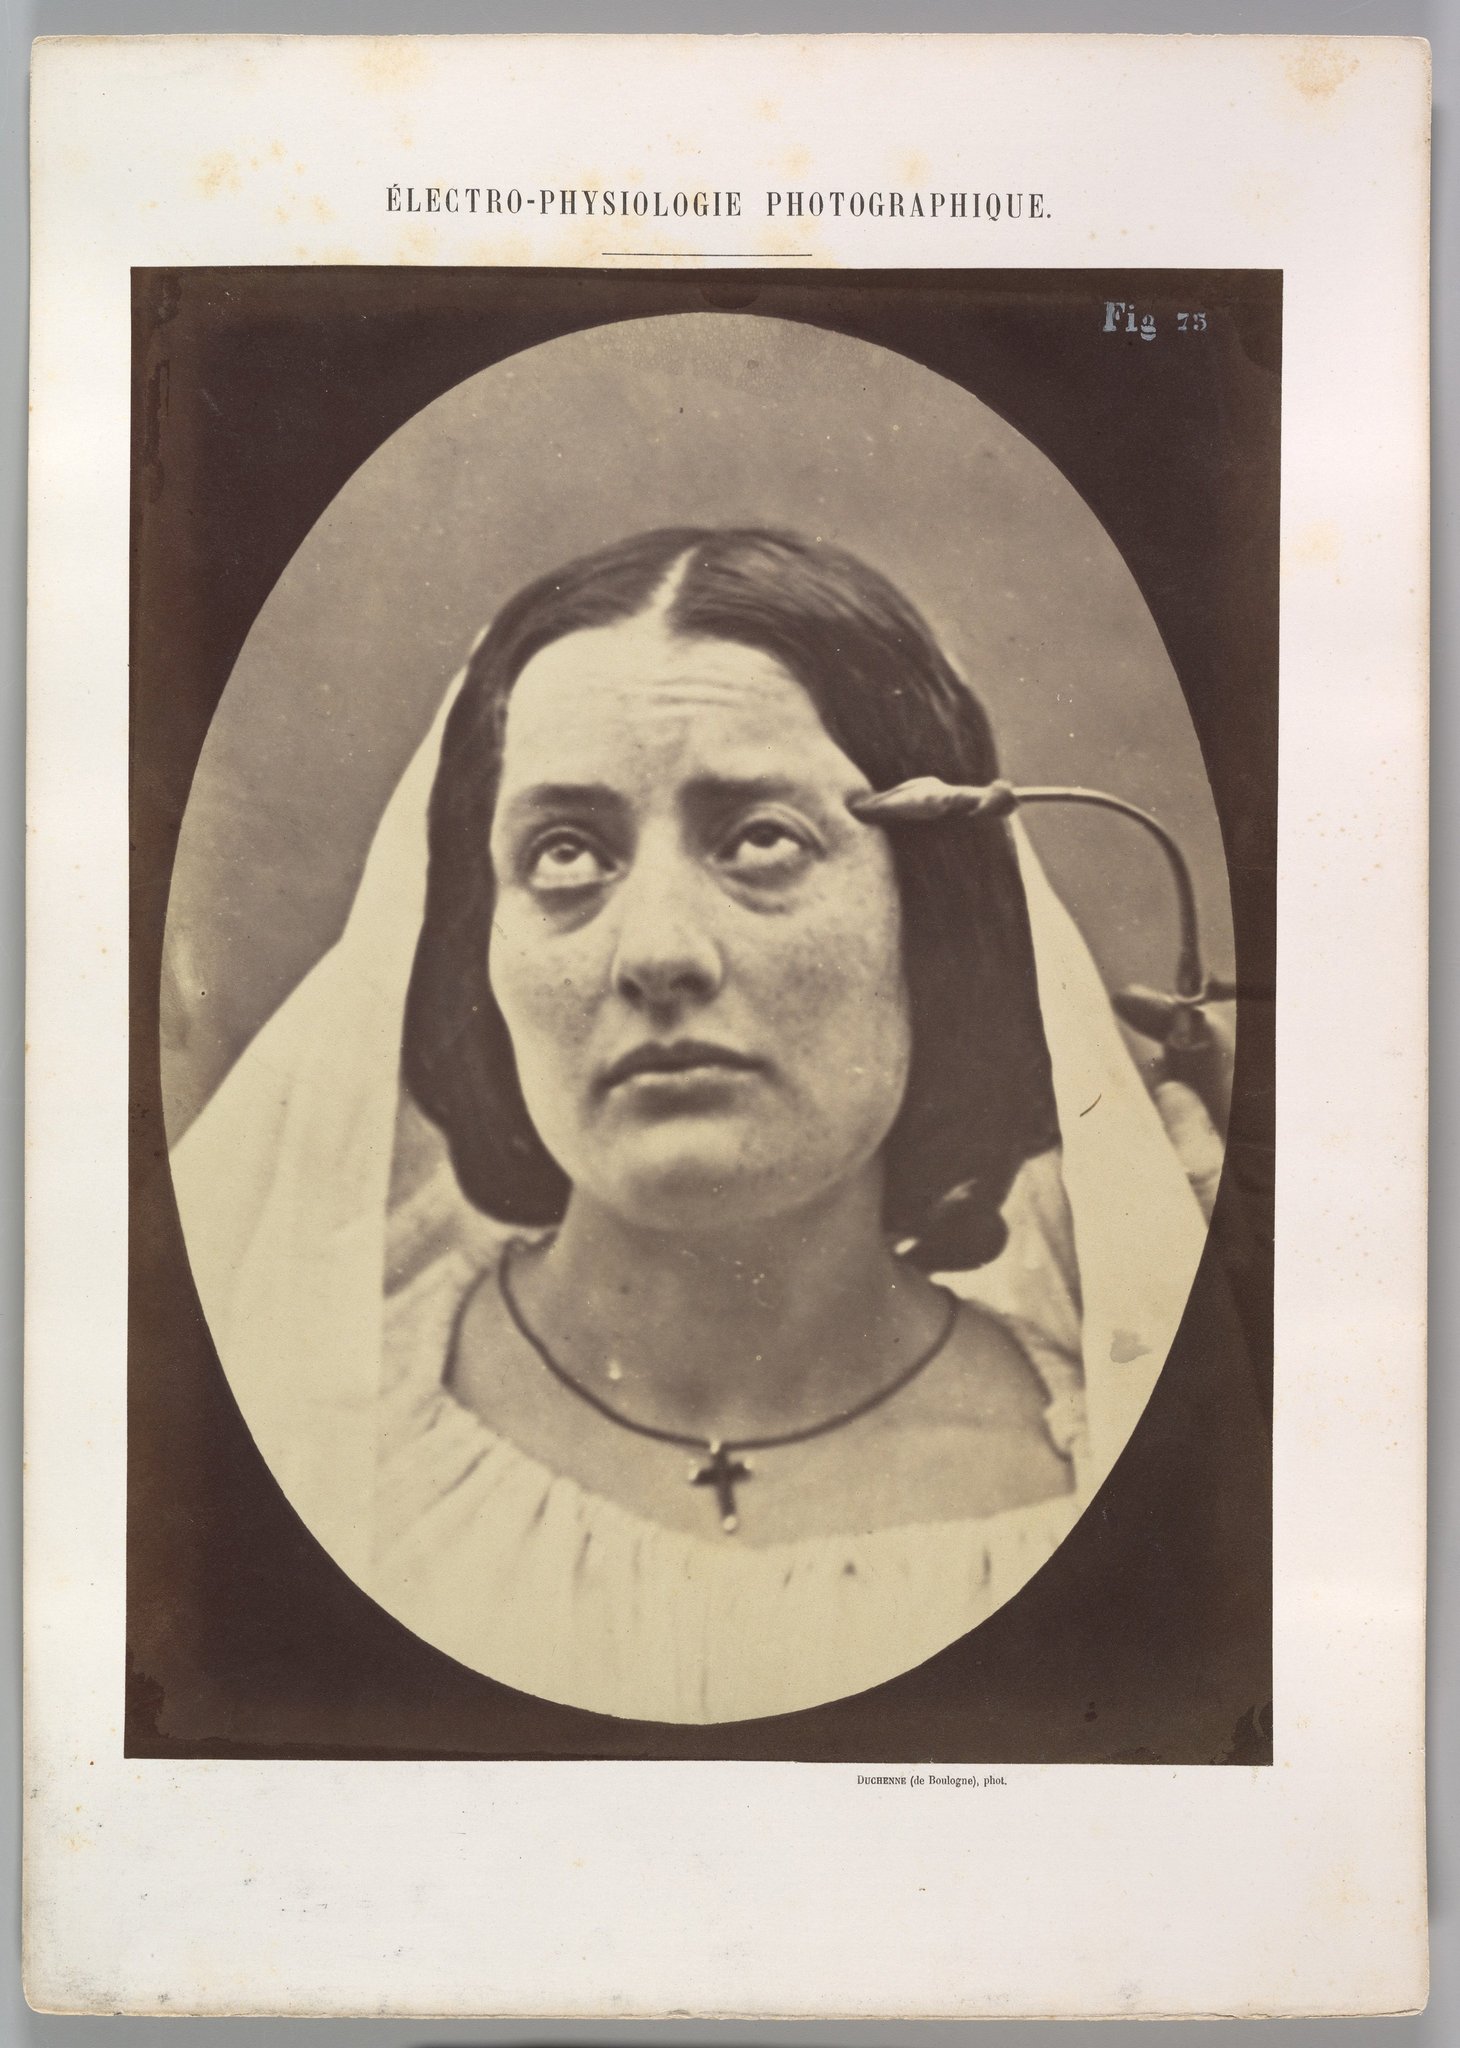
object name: photograph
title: Figure 75: Nun saying her prayers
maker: guillaume-benjamin-amand duchenne de boulogne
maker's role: artist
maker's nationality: french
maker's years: 1806-1875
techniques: albumen silver print, glass negative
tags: science,portraits,women